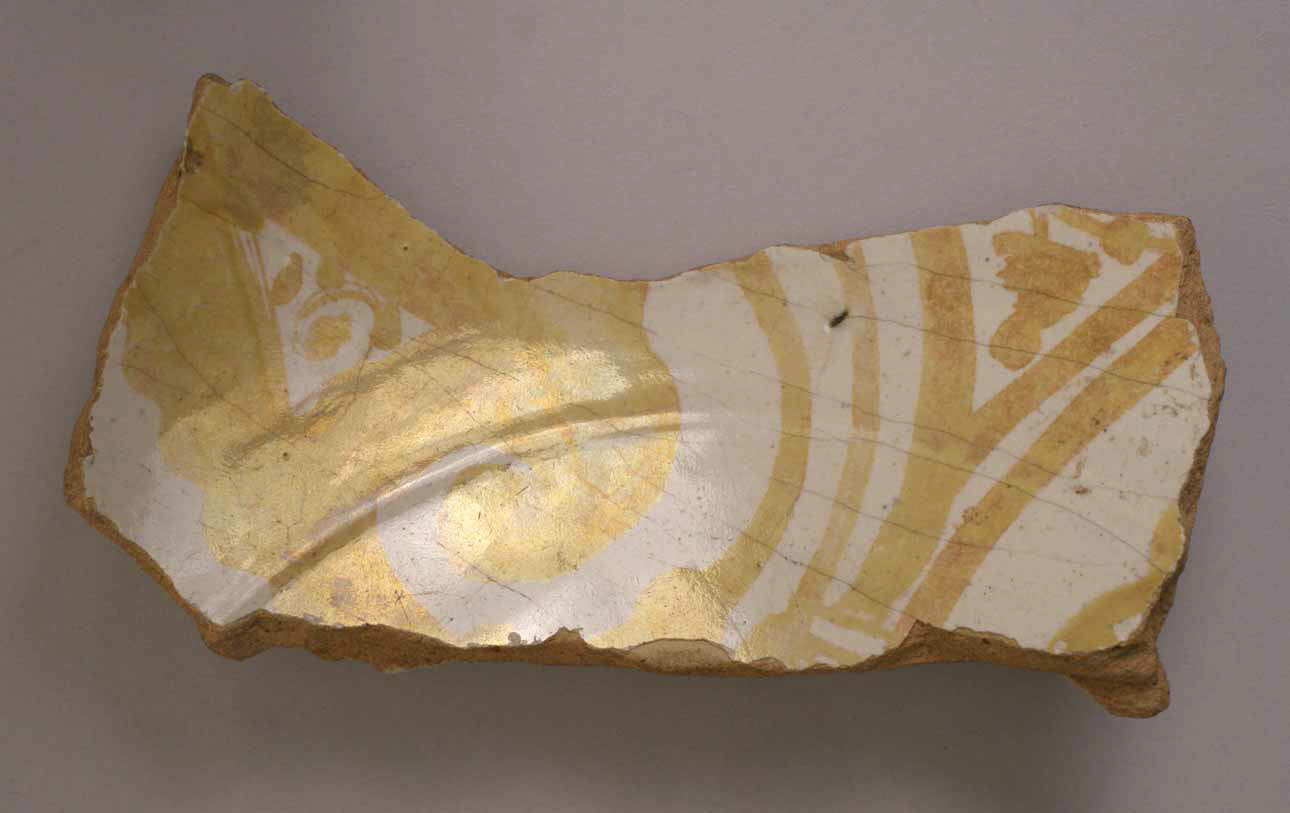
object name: ceramic fragment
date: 1001-1100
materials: earthenware, tin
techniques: enamel, luster painting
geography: egypt